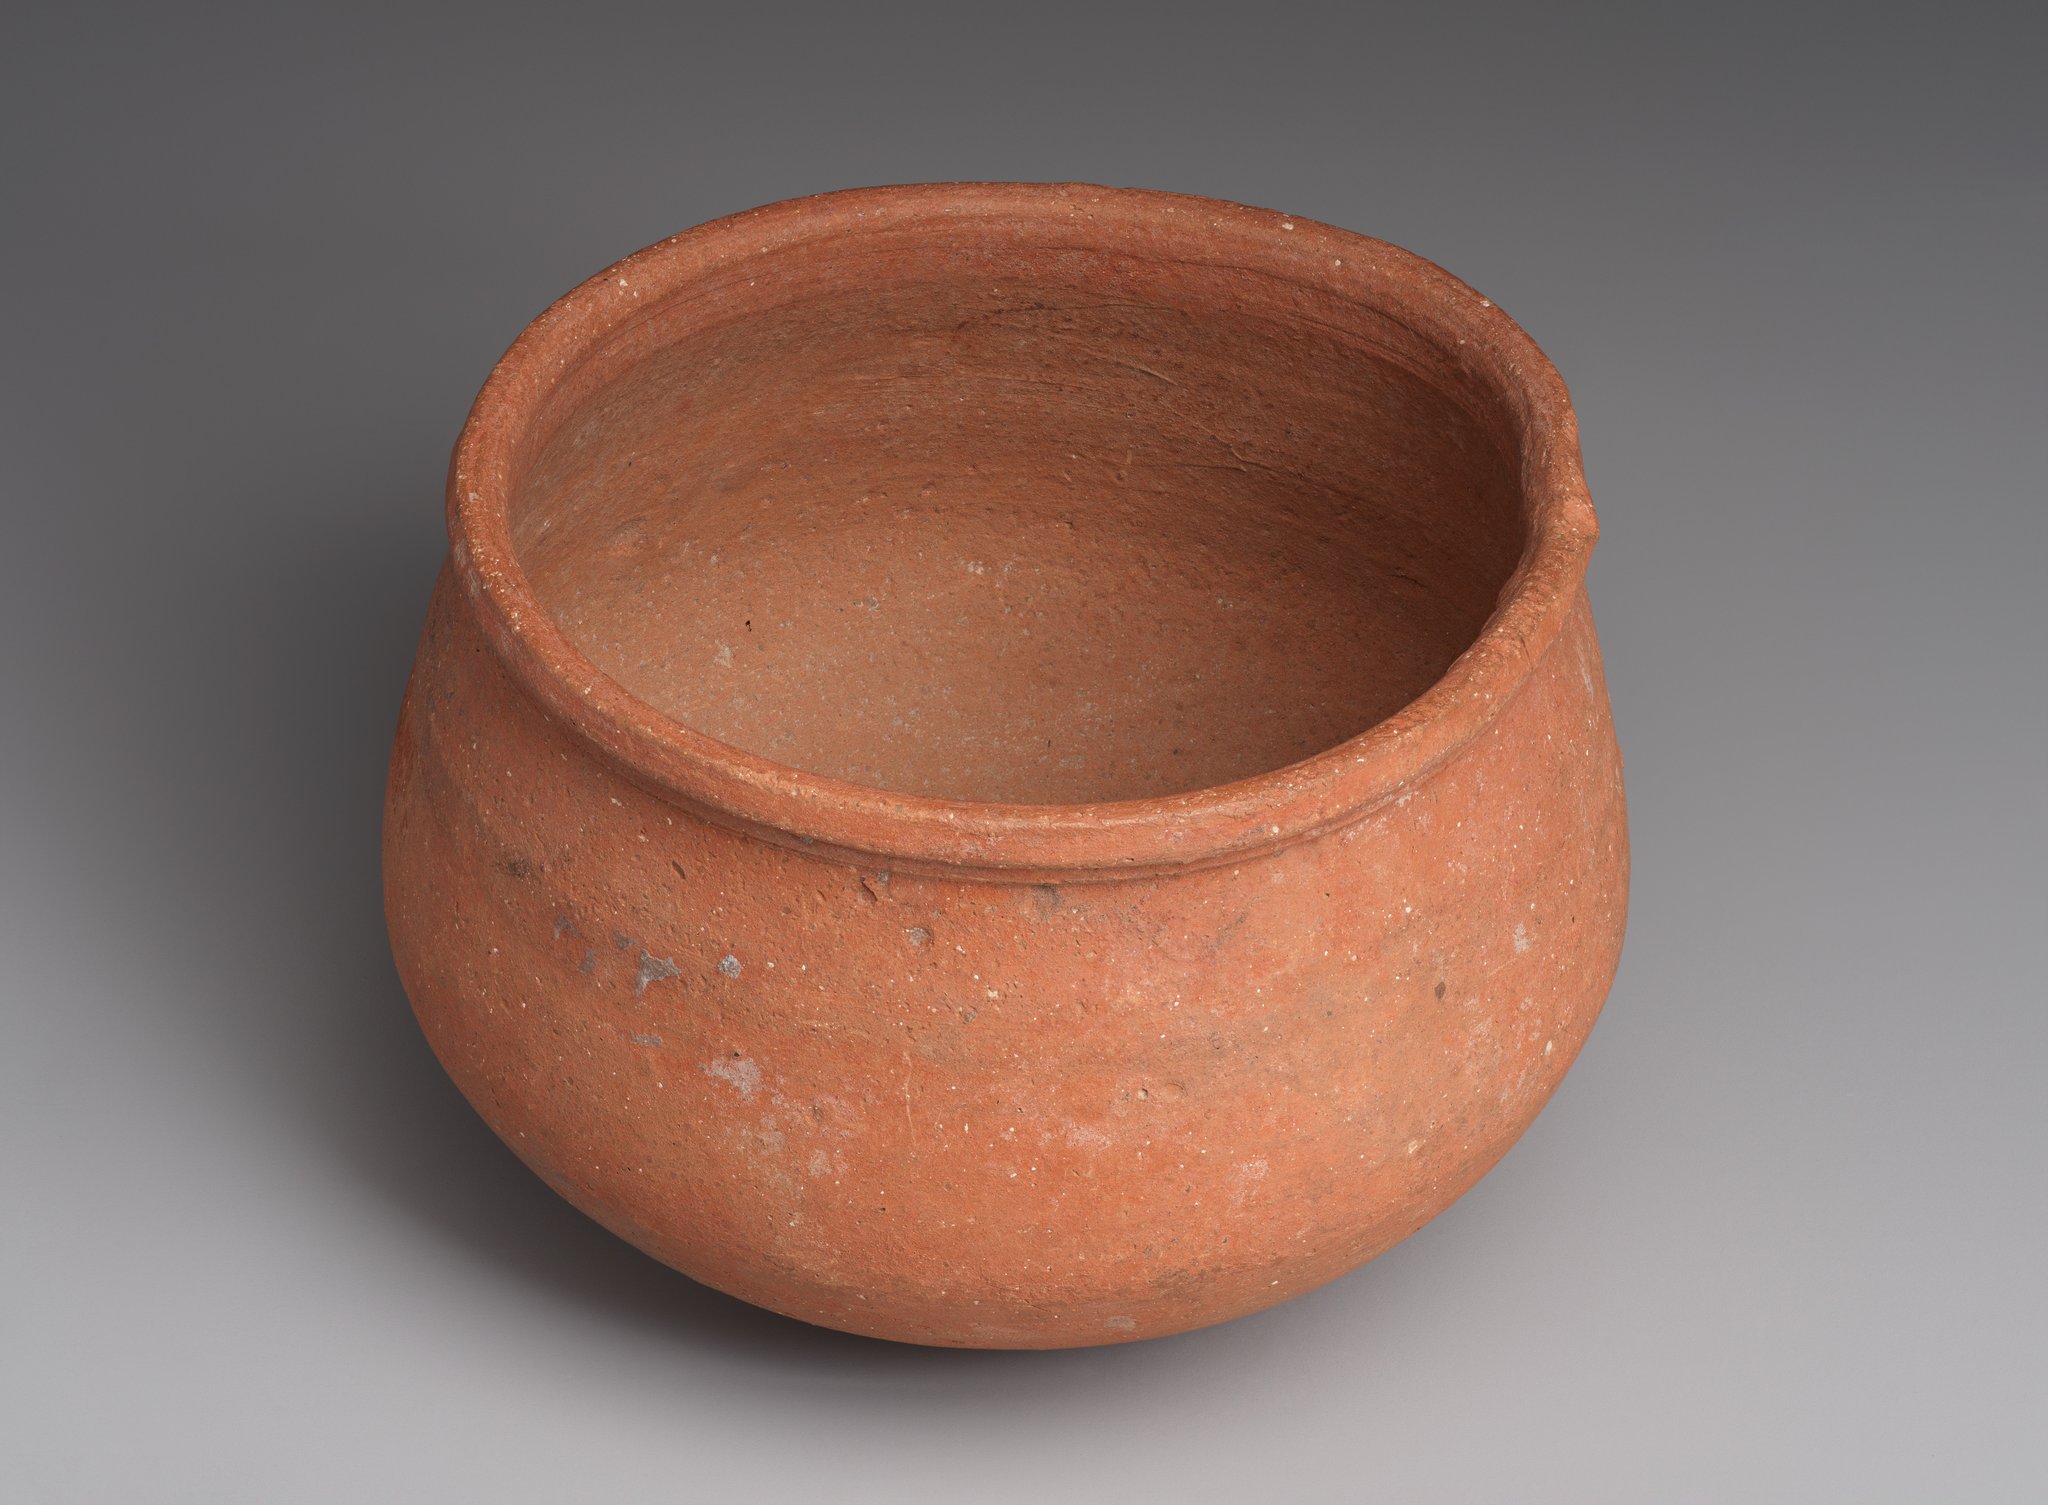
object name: bowl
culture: nabataean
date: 1-100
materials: ceramic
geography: levant